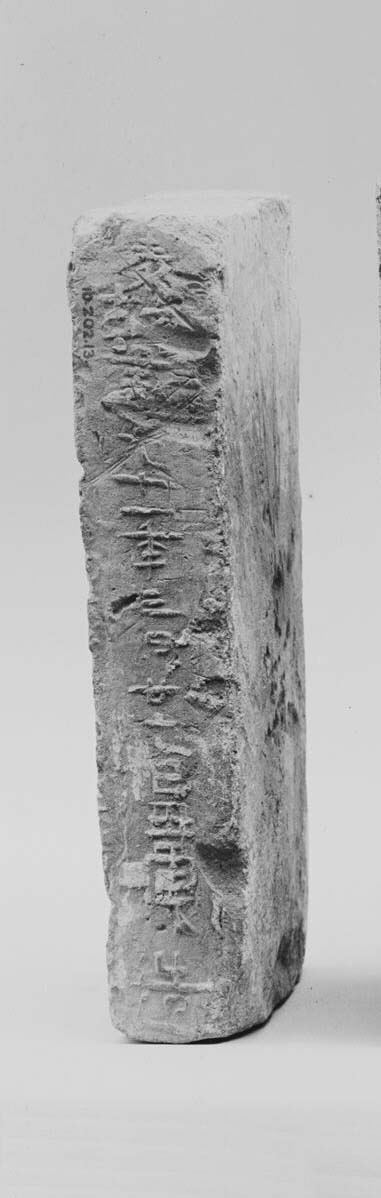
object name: tile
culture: chinese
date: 221 BCE-220 CE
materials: earthenware